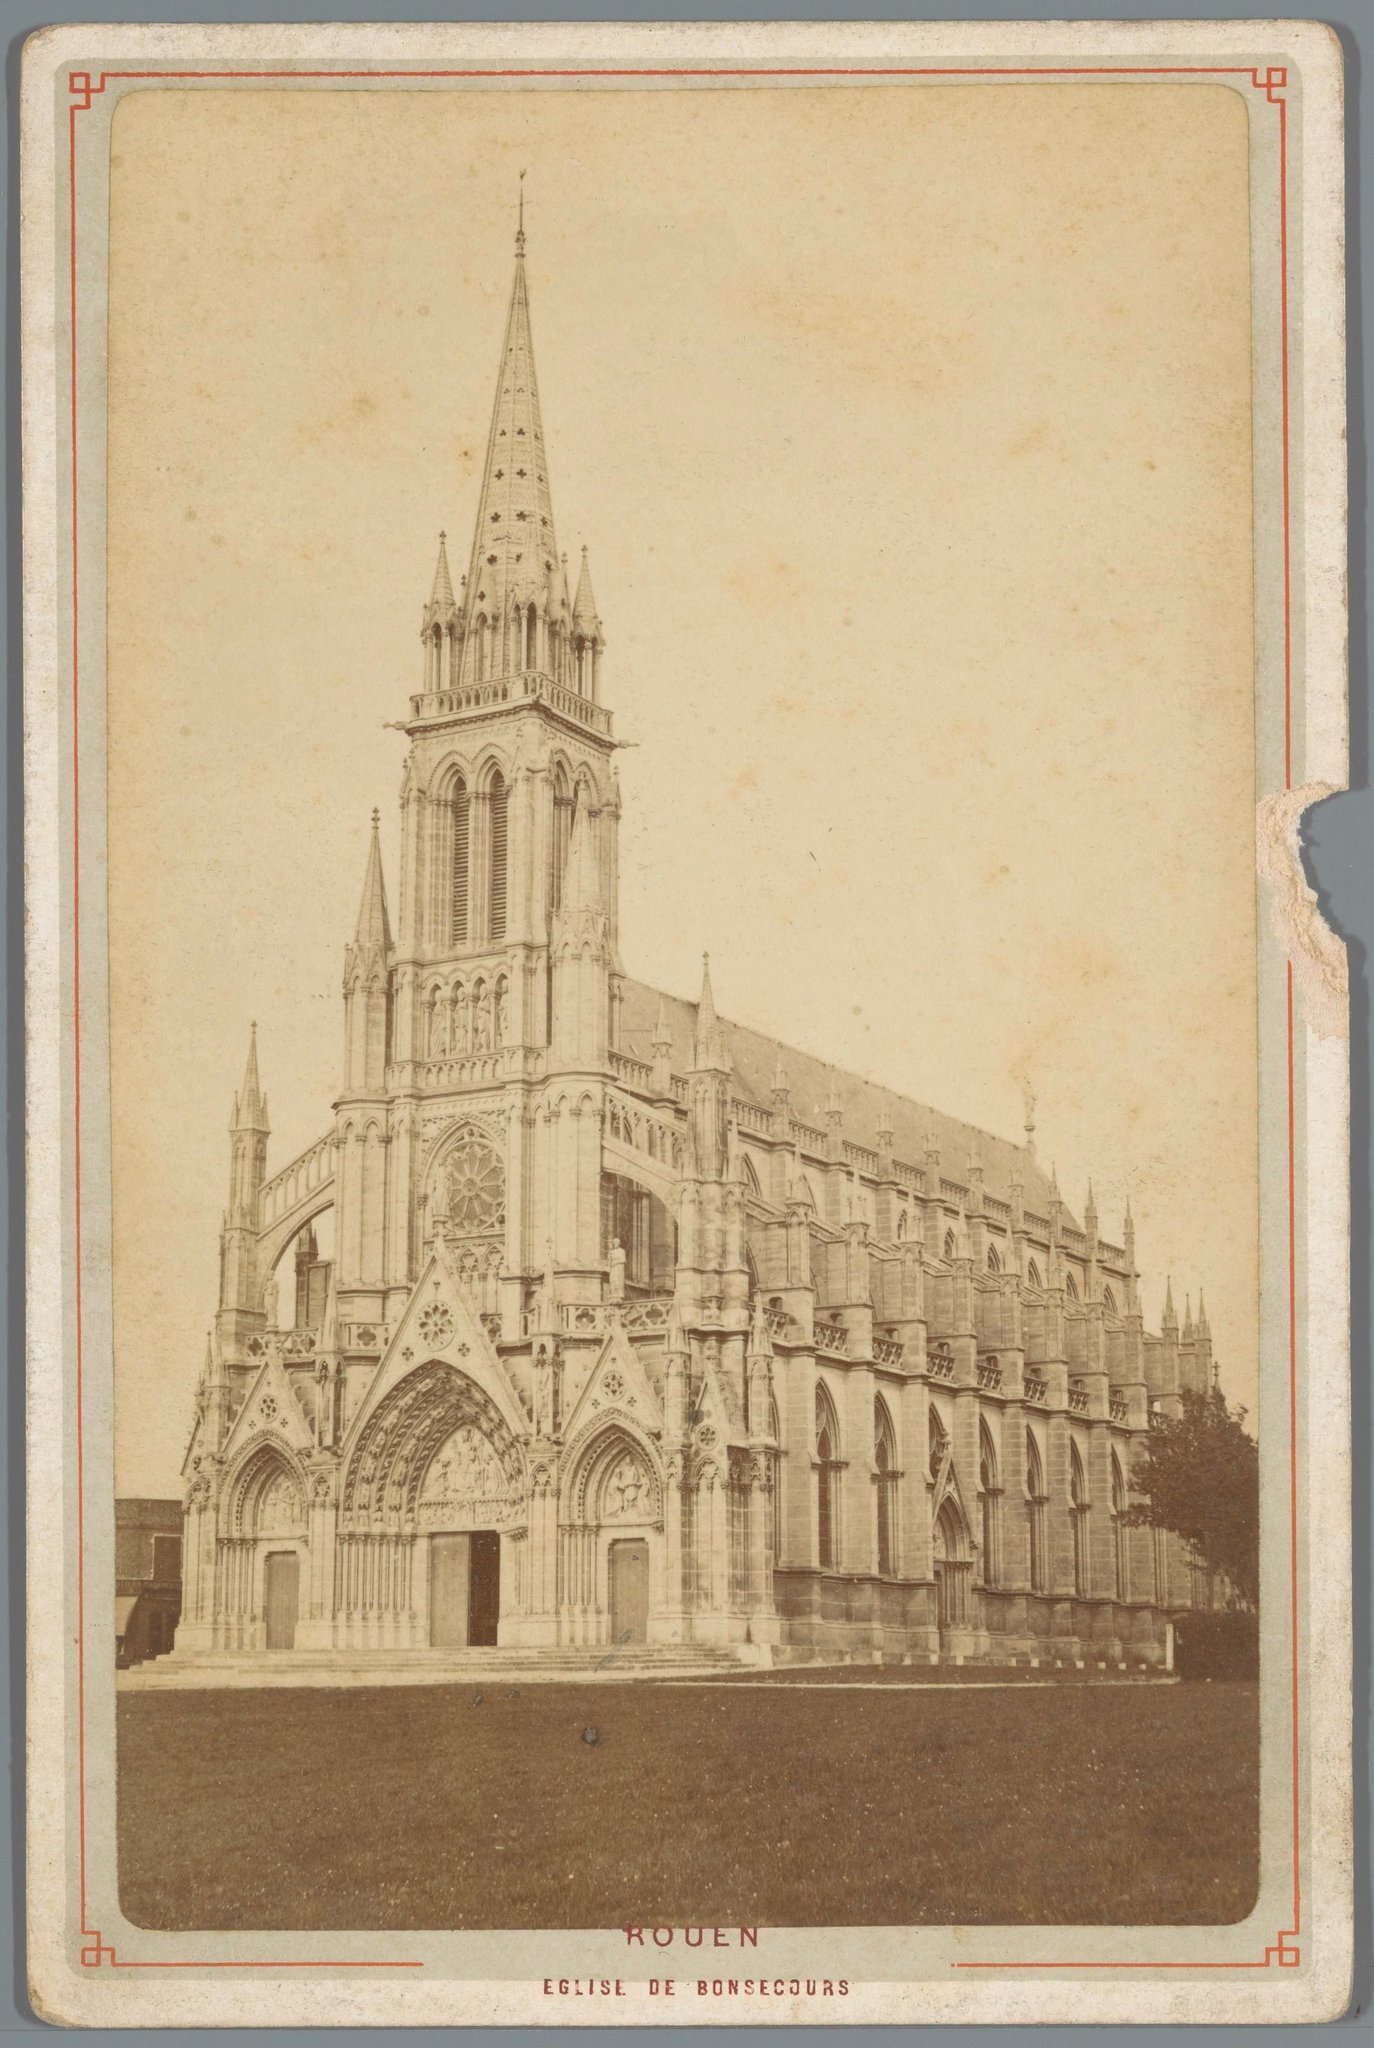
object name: cabinet photograph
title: Rouen. Eglise de Bonsecours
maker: Anonymous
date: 1870-1890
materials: cardboard, paper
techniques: albumen print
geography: bonsecours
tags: church (exterior)